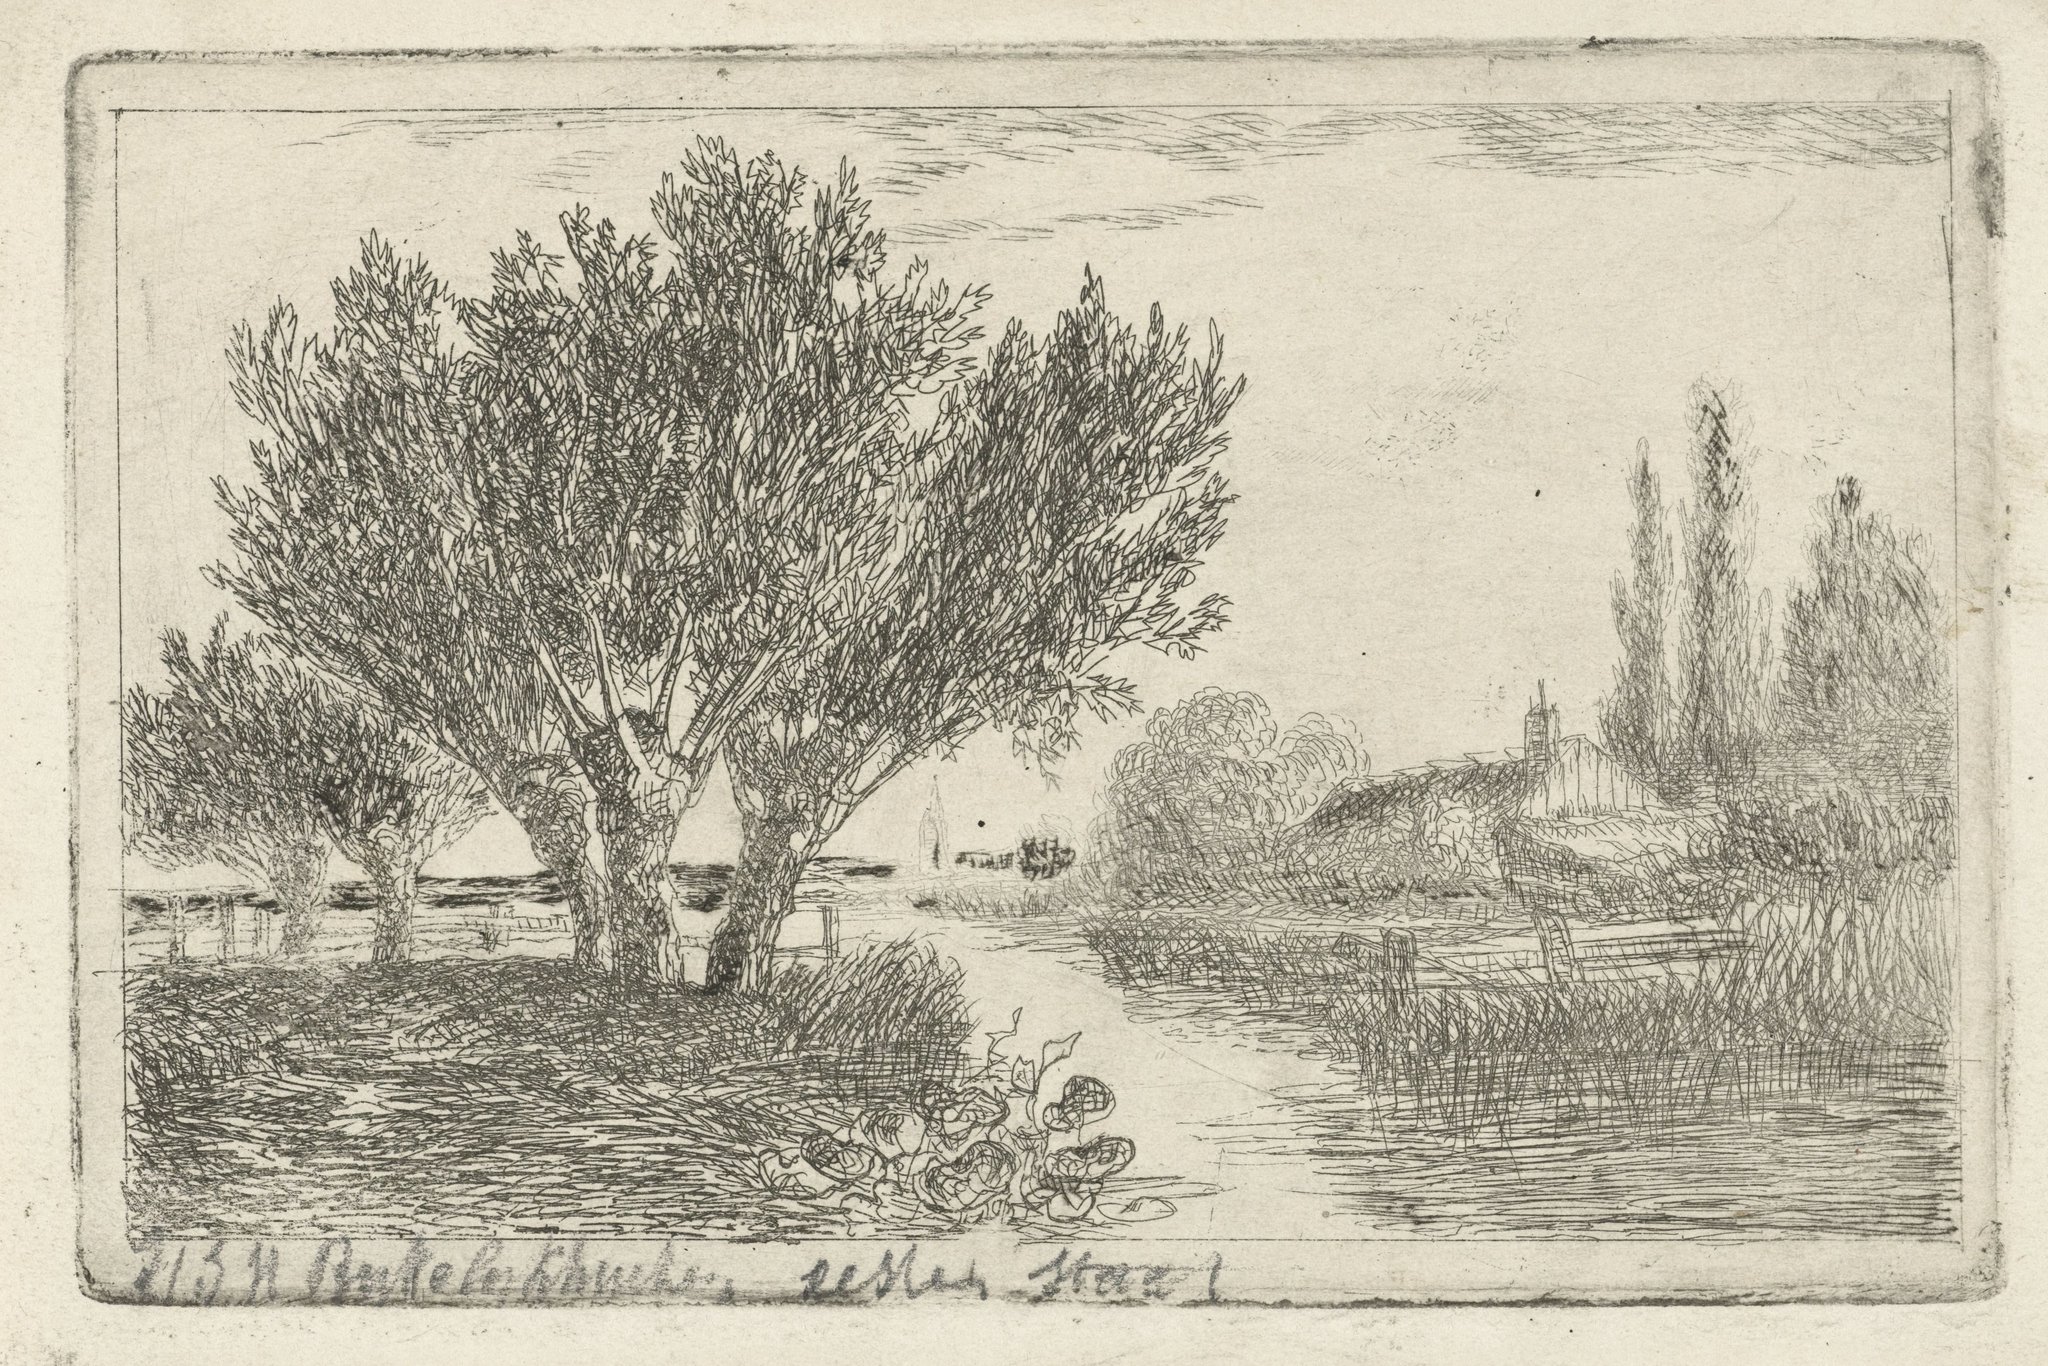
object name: print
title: Knotwilgen aan een rivier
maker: hermanus jan hendrik van rijkelijkhuysen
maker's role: painter, print maker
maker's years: 1813-1883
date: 1823-1883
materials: paper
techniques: etching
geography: utrecht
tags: river, church (exterior), trees: willow, farm or solitary house in landscape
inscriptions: collector's mark: Lugt 2228, inscription: ‘HJH Rijkelijkhuysen [...] staat’